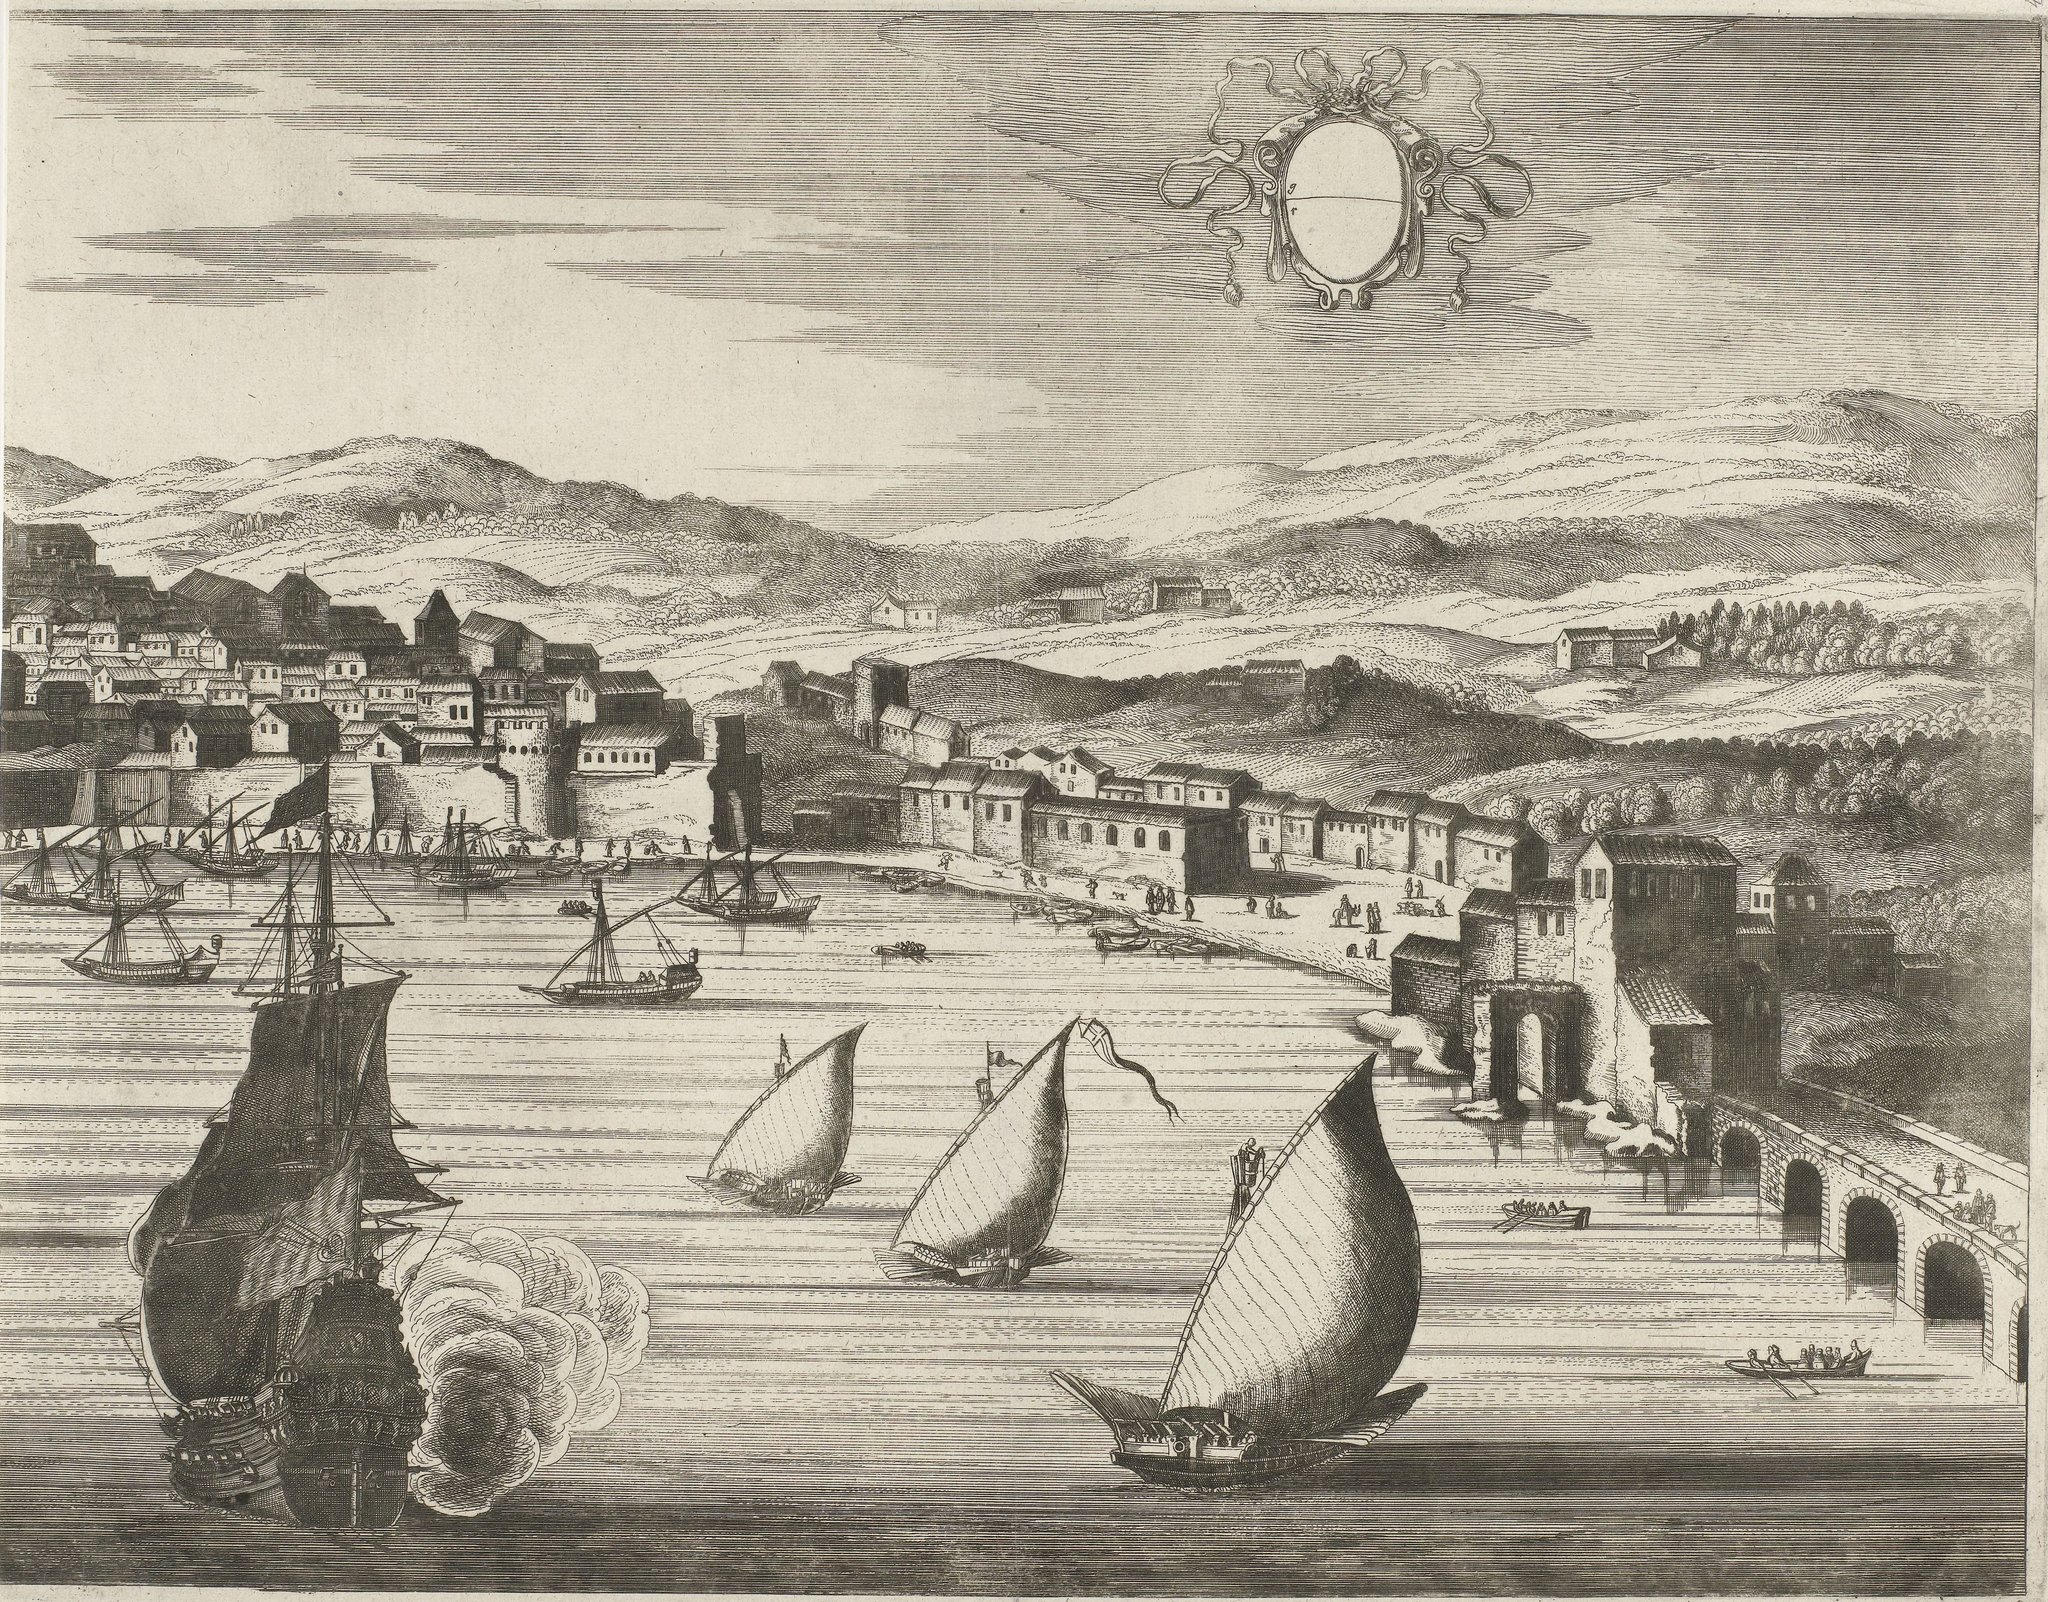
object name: print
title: Gezicht op Napels (blad 4)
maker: jan van de velde (ii)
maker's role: draughtsman, painter, print maker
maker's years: 1593-1641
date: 1618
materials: paper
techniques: etching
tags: prospect of city, town panorama, silhouette of city, naples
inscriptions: collector's mark: Lugt 2228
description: Rechter blad van een fries van vier bladen met een gezicht op Napels, gedrukt van vier platen.